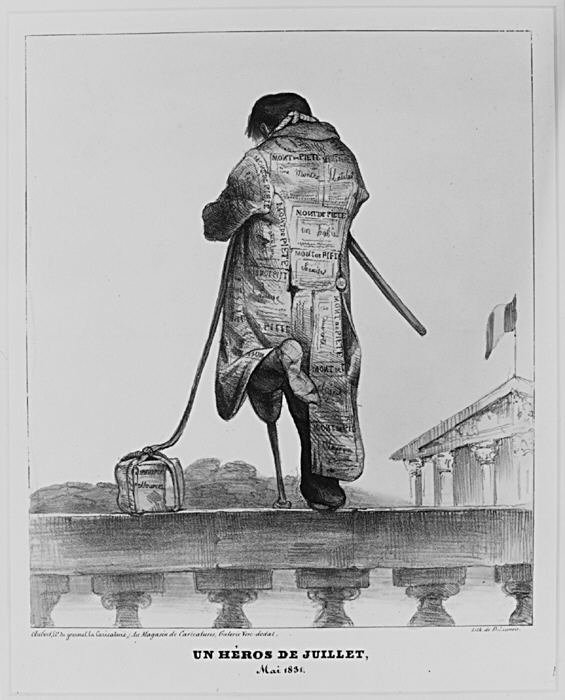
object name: print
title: Un héros de juillet, Mai 1831, published in La Caricature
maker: honoré daumier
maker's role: artist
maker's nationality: french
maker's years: 1808-1879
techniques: lithograph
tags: satire,men